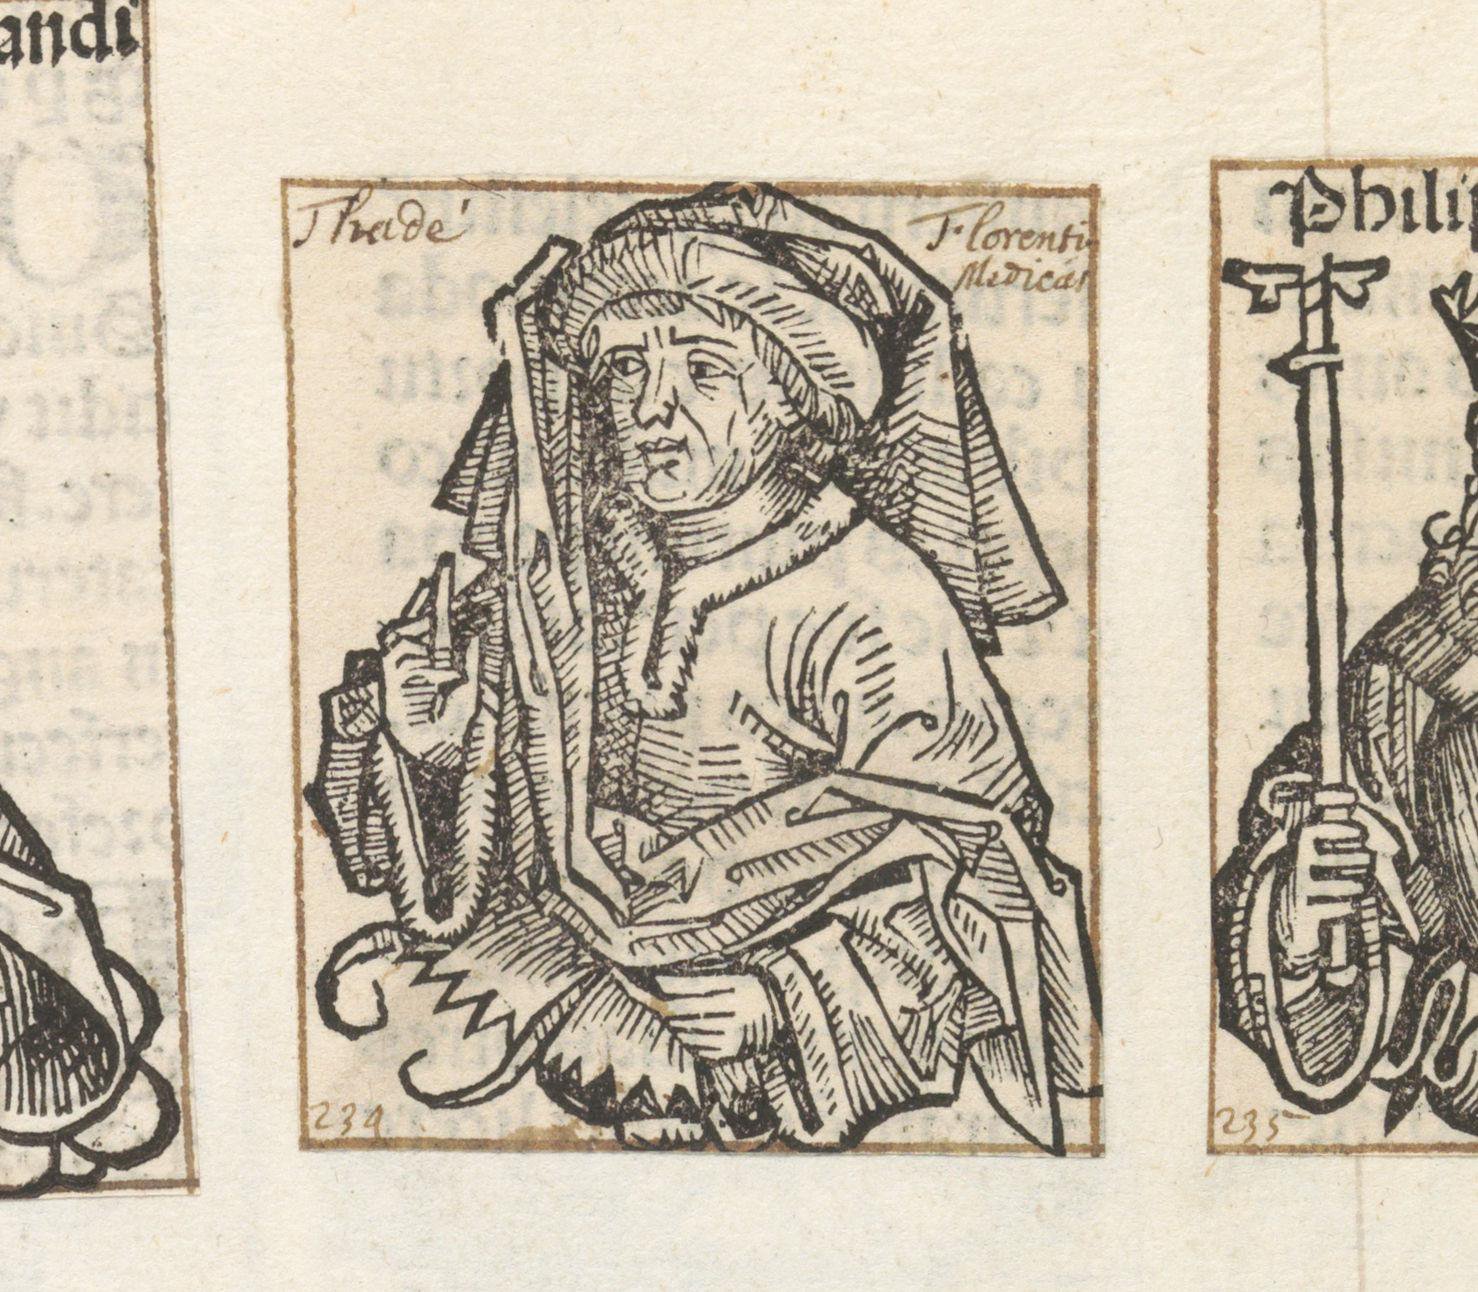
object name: album leaf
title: Taddeo Alderotti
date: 1493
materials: paper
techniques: letterpress printing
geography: nuremberg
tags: florence, taddeo alderotti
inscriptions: inscription: ‘234’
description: De houtsnede wordt herhaaldelijk gebruikt als boekillustratie in de Liber Chronicarum (of Neurenbergkroniek) van Hartmann Schedel, verschenen in het Latijn en Duits in 1493. Zie de Latijnse uitgave, folio 218r.